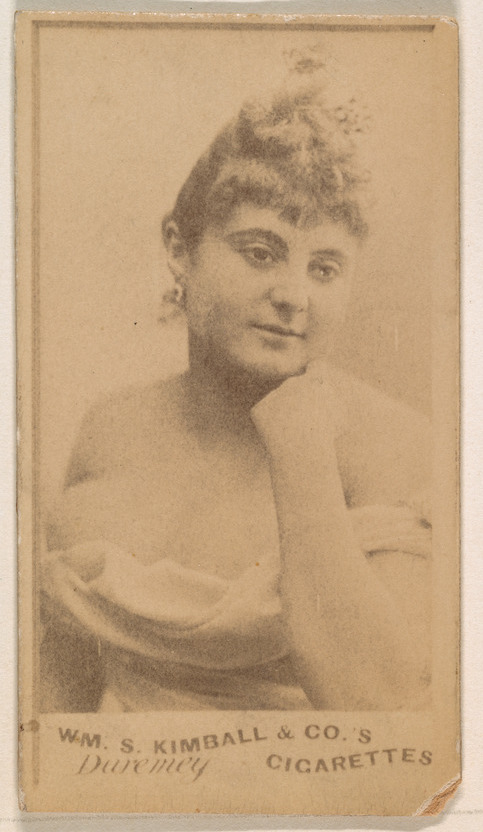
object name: photograph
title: Miss Duremey, from the Actresses series (N203) issued by Wm. S. Kimball & Co.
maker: william s. kimball & company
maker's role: publisher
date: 1889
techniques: color lithograph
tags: portraits,women,actresses